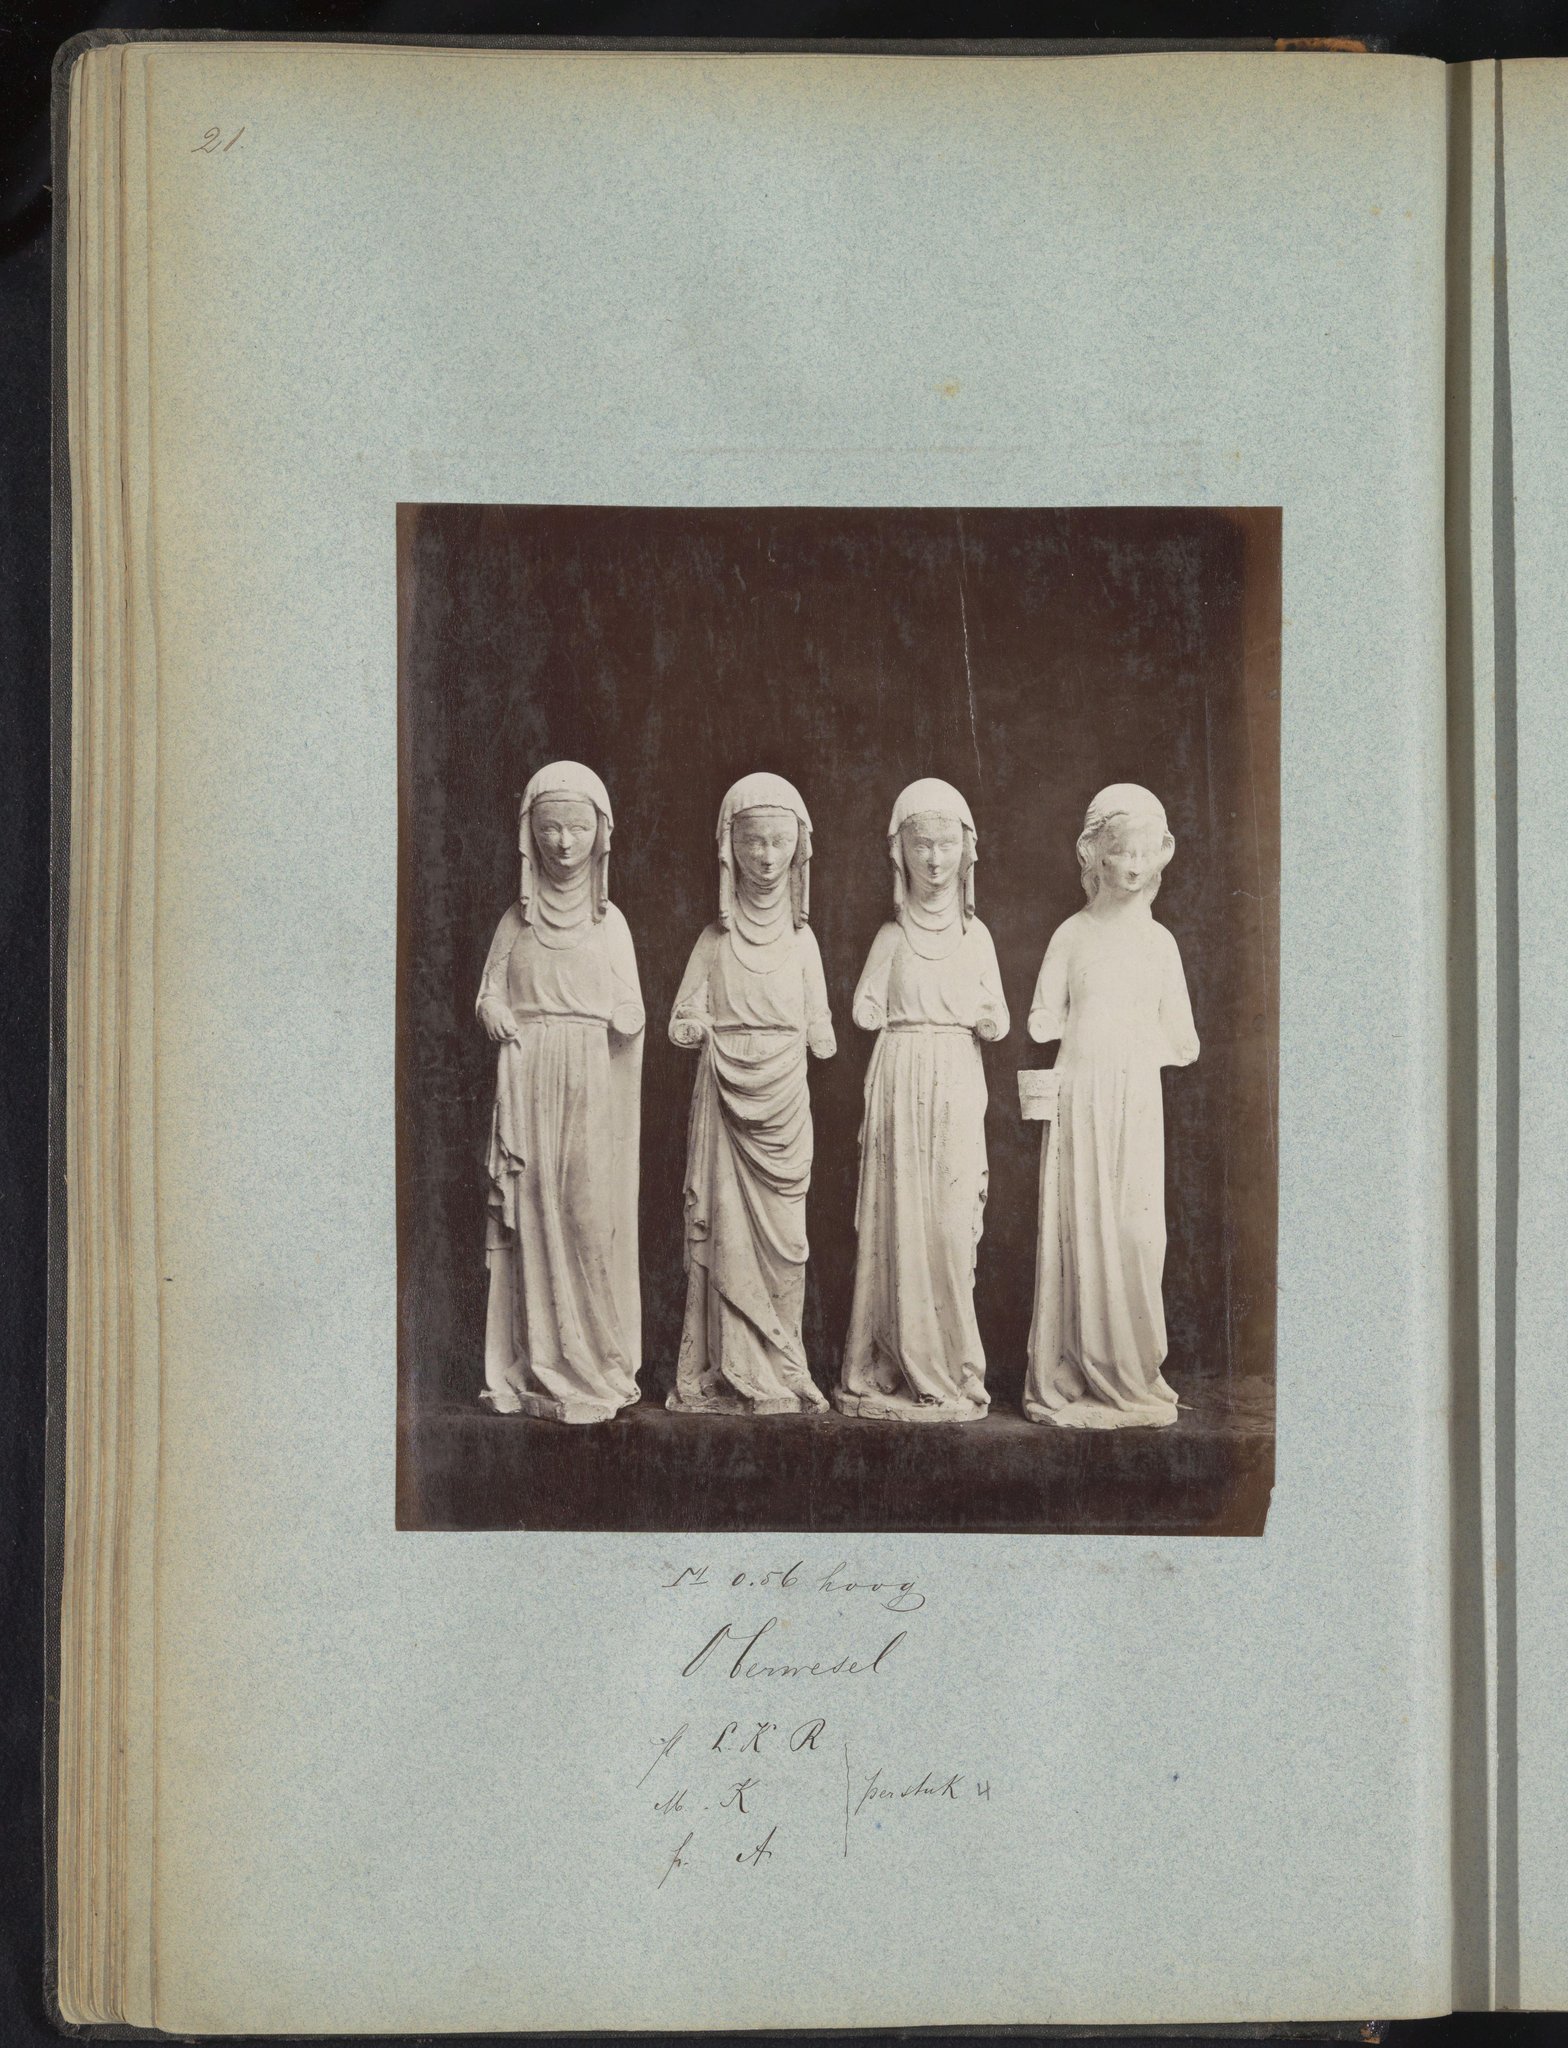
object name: album leaf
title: Vier gipsen afgietsels van sculpturen, vermoedelijk uit een kerk in Oberwesel, Duitsland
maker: Anonymous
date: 1875-1900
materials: paper, photographic support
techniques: albumen print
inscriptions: annotation: ‘M 0.56 hoog’, annotation: ‘Oberwesel’, annotation